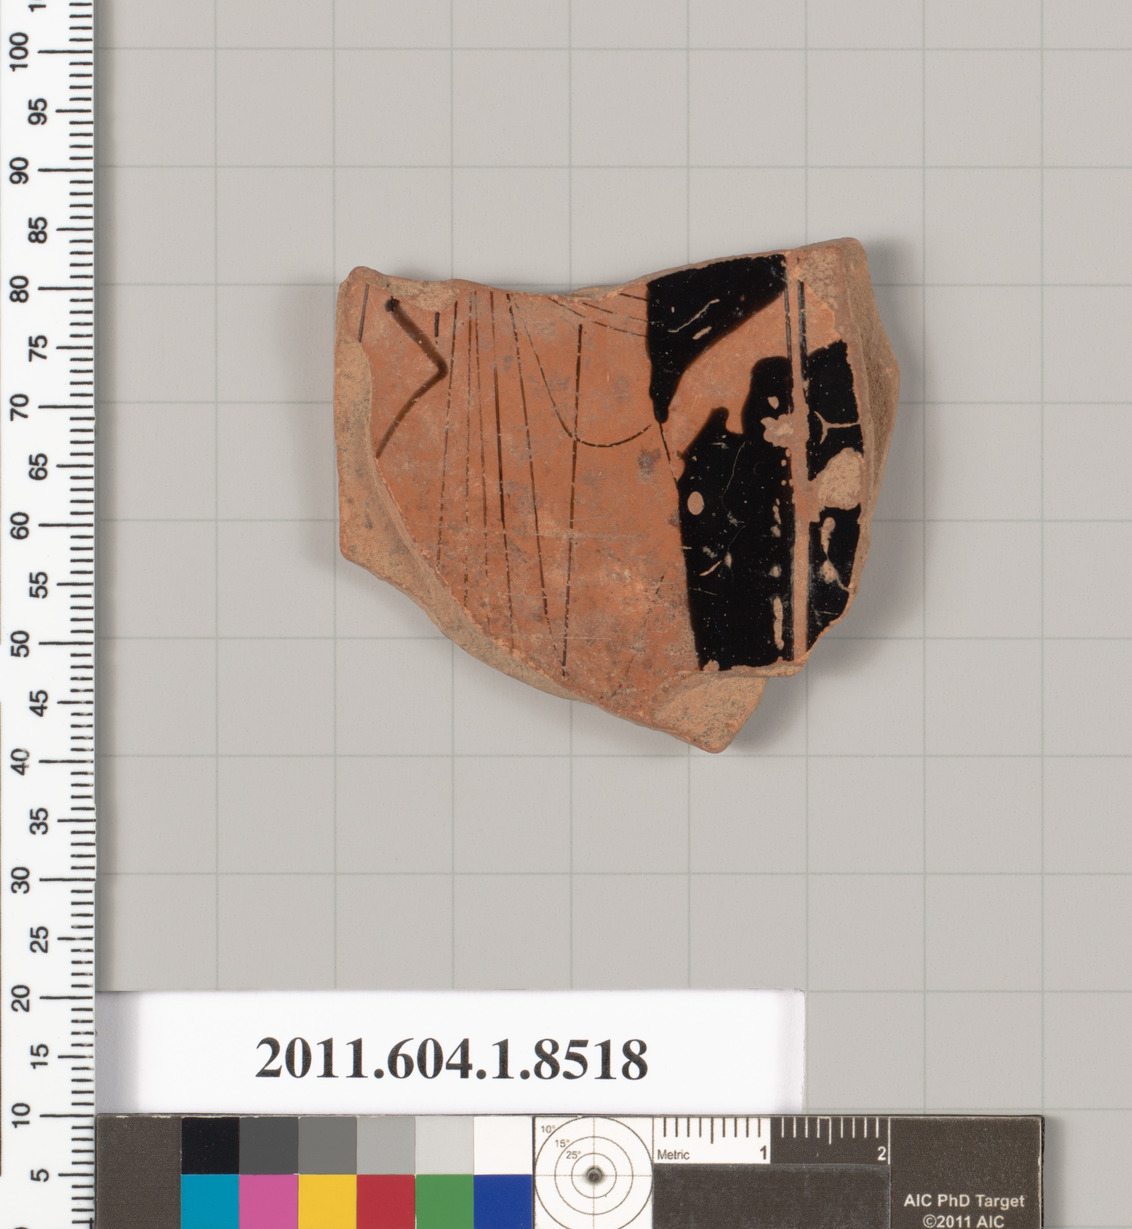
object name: kylix fragment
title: Terracotta fragment of a stemless kylix (drinking cup)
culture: greek, attic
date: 470-450 BCE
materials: terracotta